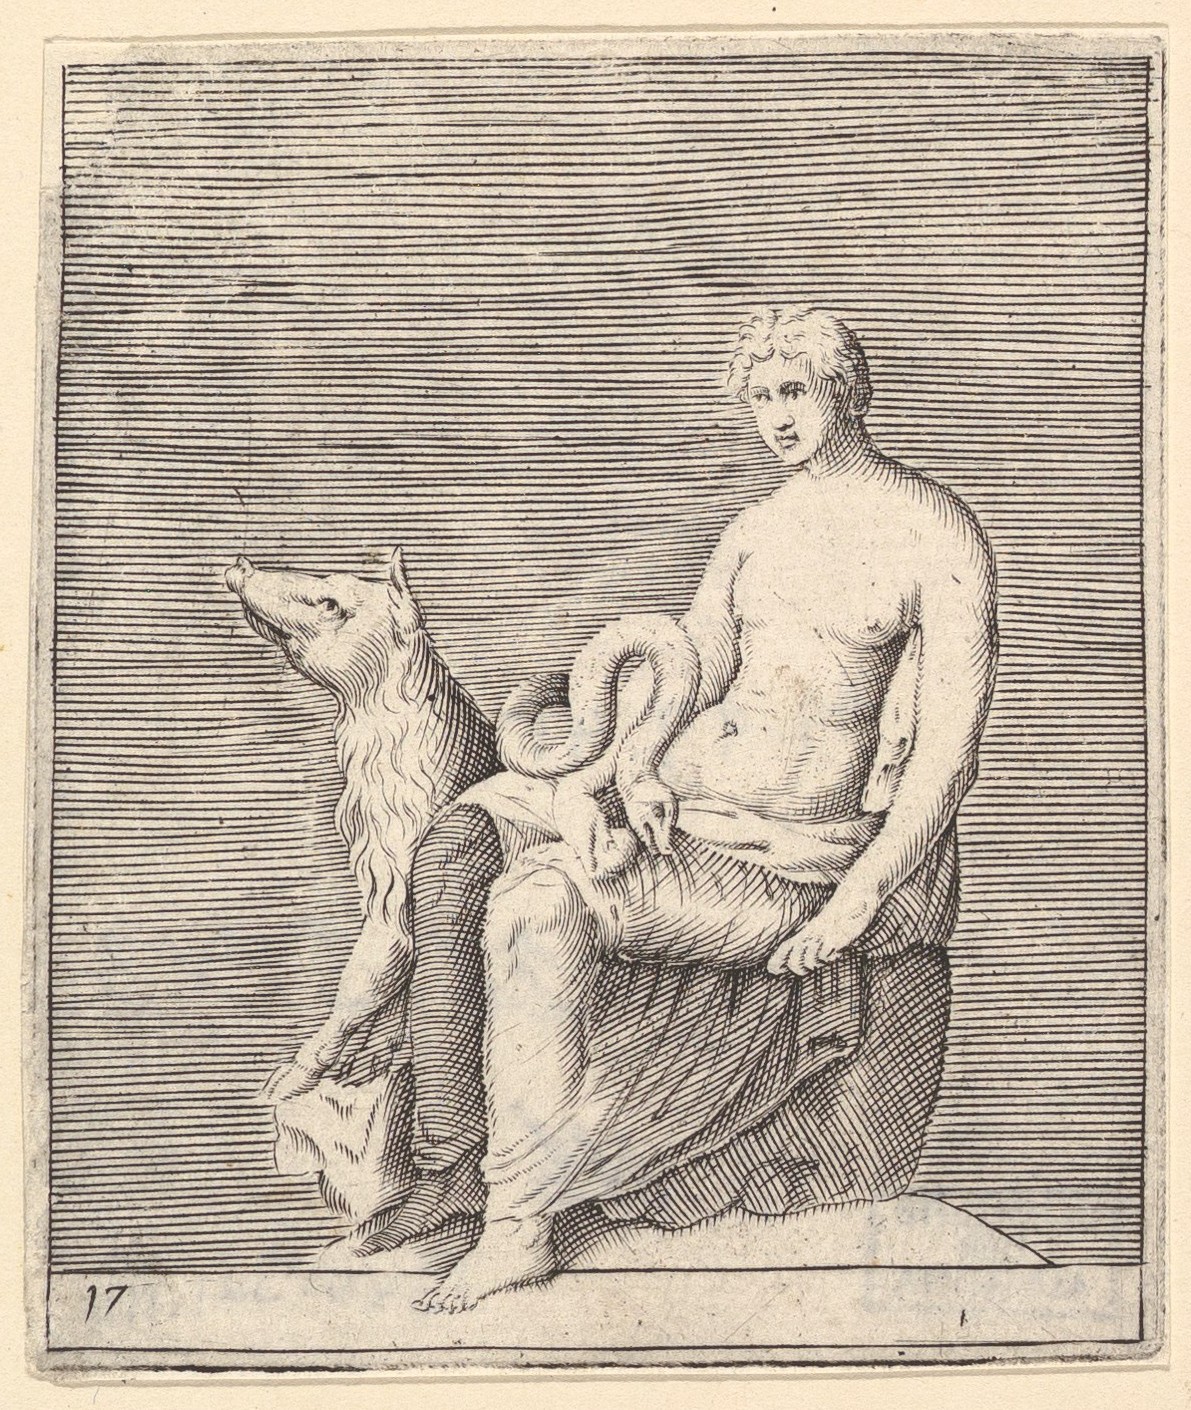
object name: print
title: Figure with Pig and Serpent, from "Ex Antiquis Cameorum et Gemmae Delineata/ Liber Secundus/et ab Enea Vico Parmen Incis"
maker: anonymous, italian, 16th century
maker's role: artist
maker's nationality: italian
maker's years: 1500-1600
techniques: engraving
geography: rome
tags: men,pigs,snakes